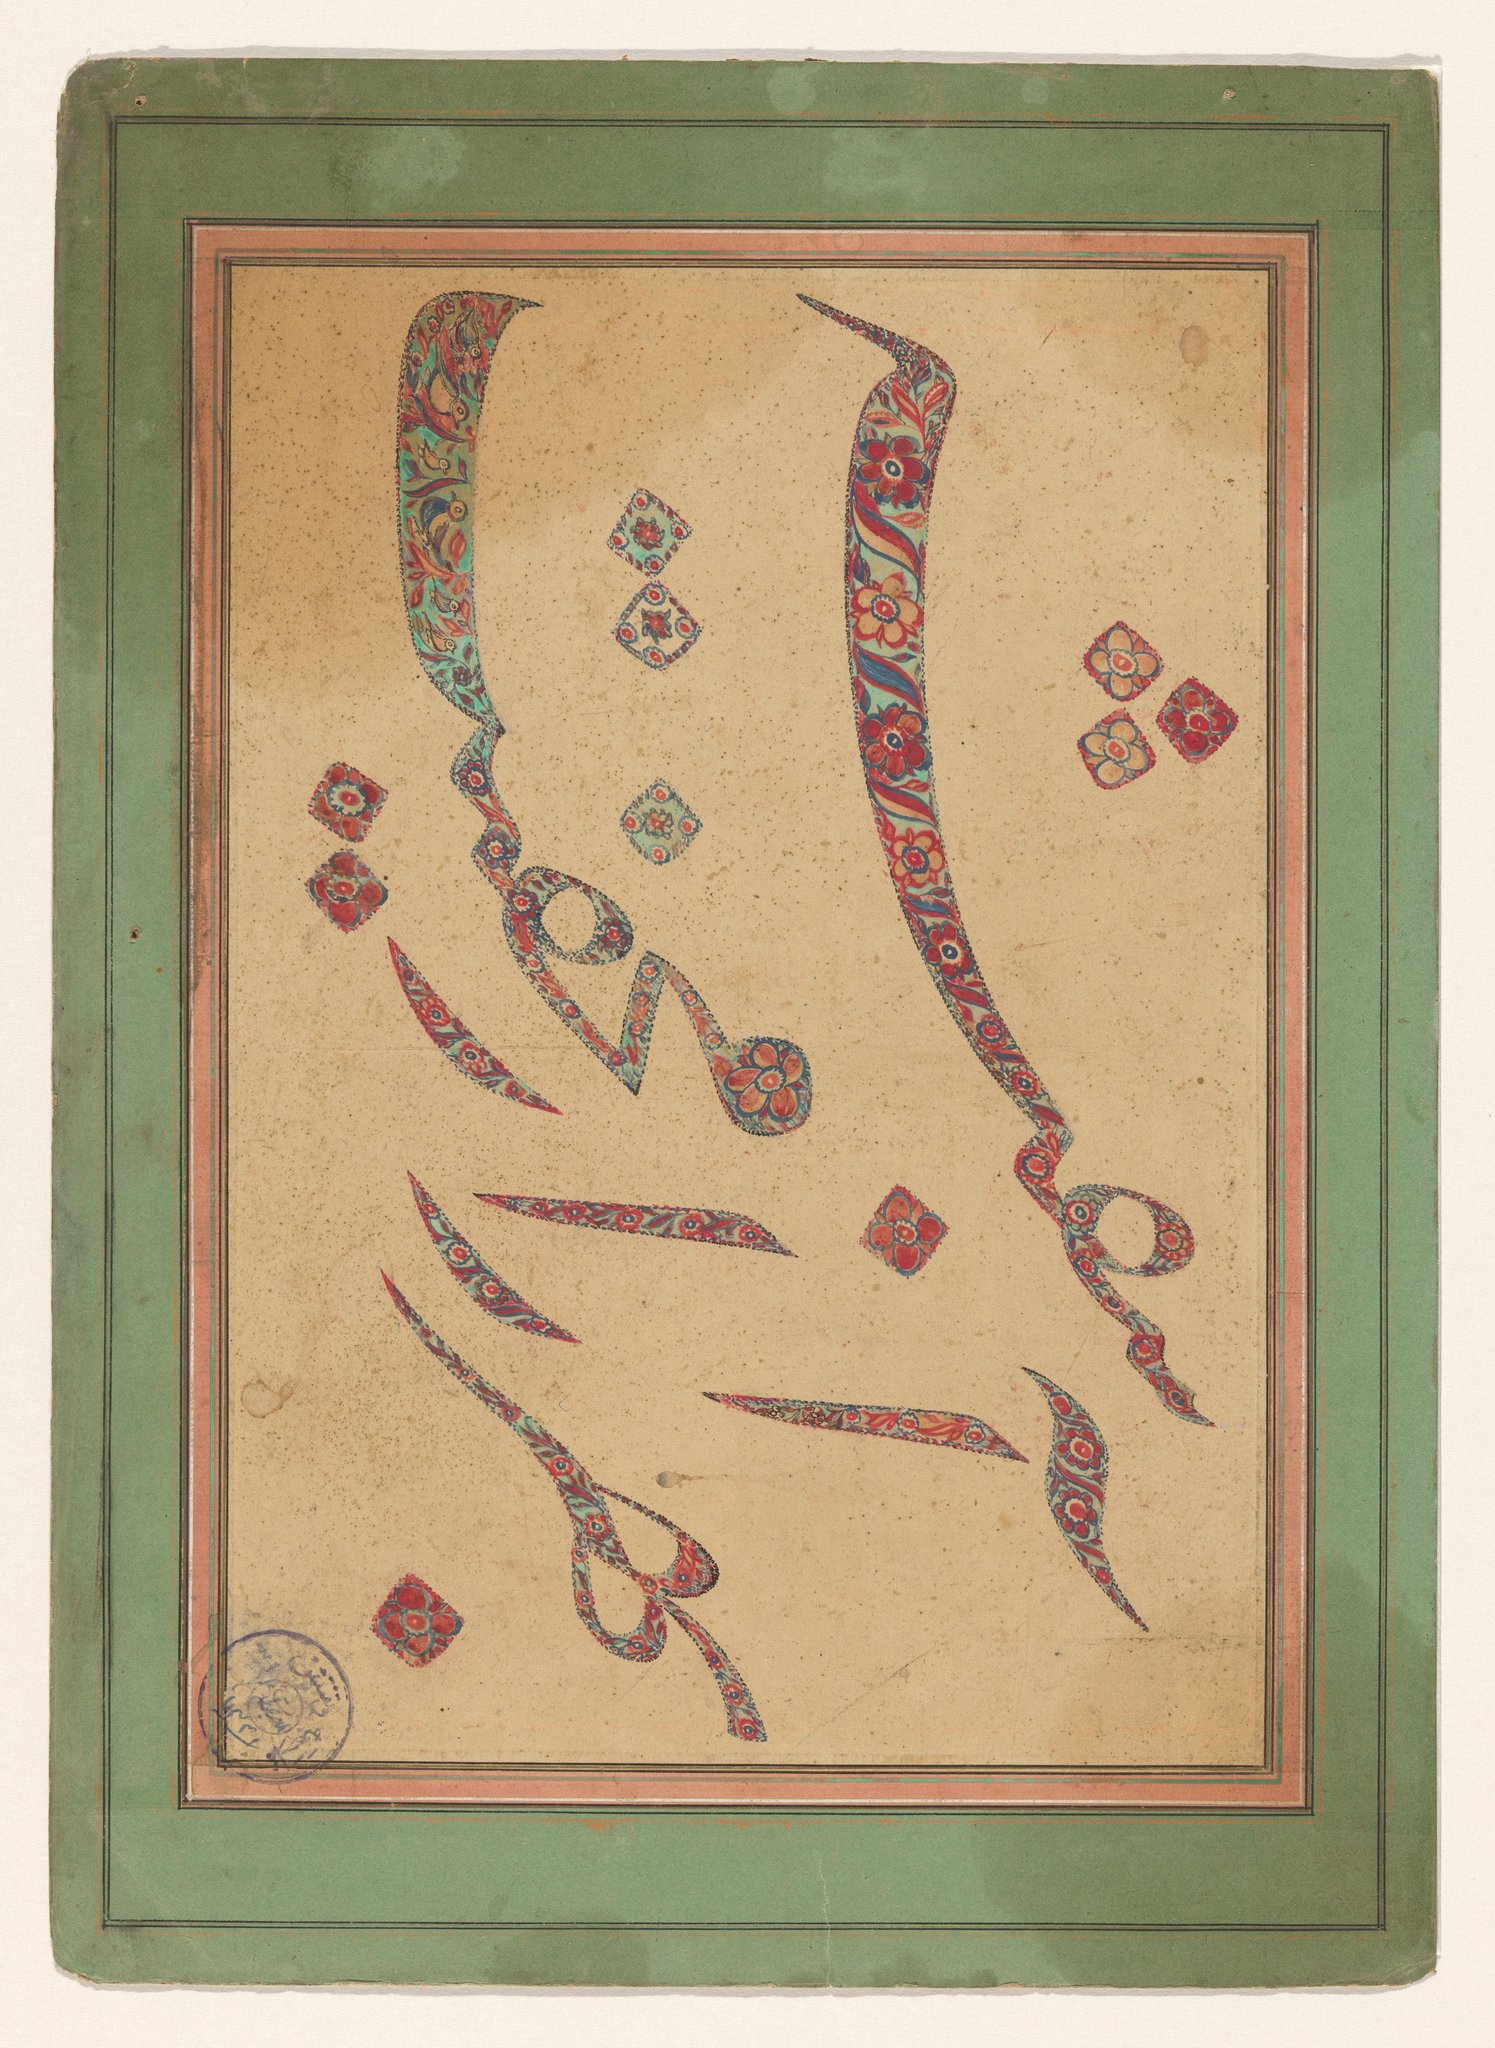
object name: persian miniature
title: Kalligrafische tekst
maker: Anonymous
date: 1700-1899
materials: paper, watercolor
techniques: brush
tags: calligraphy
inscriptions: stamp